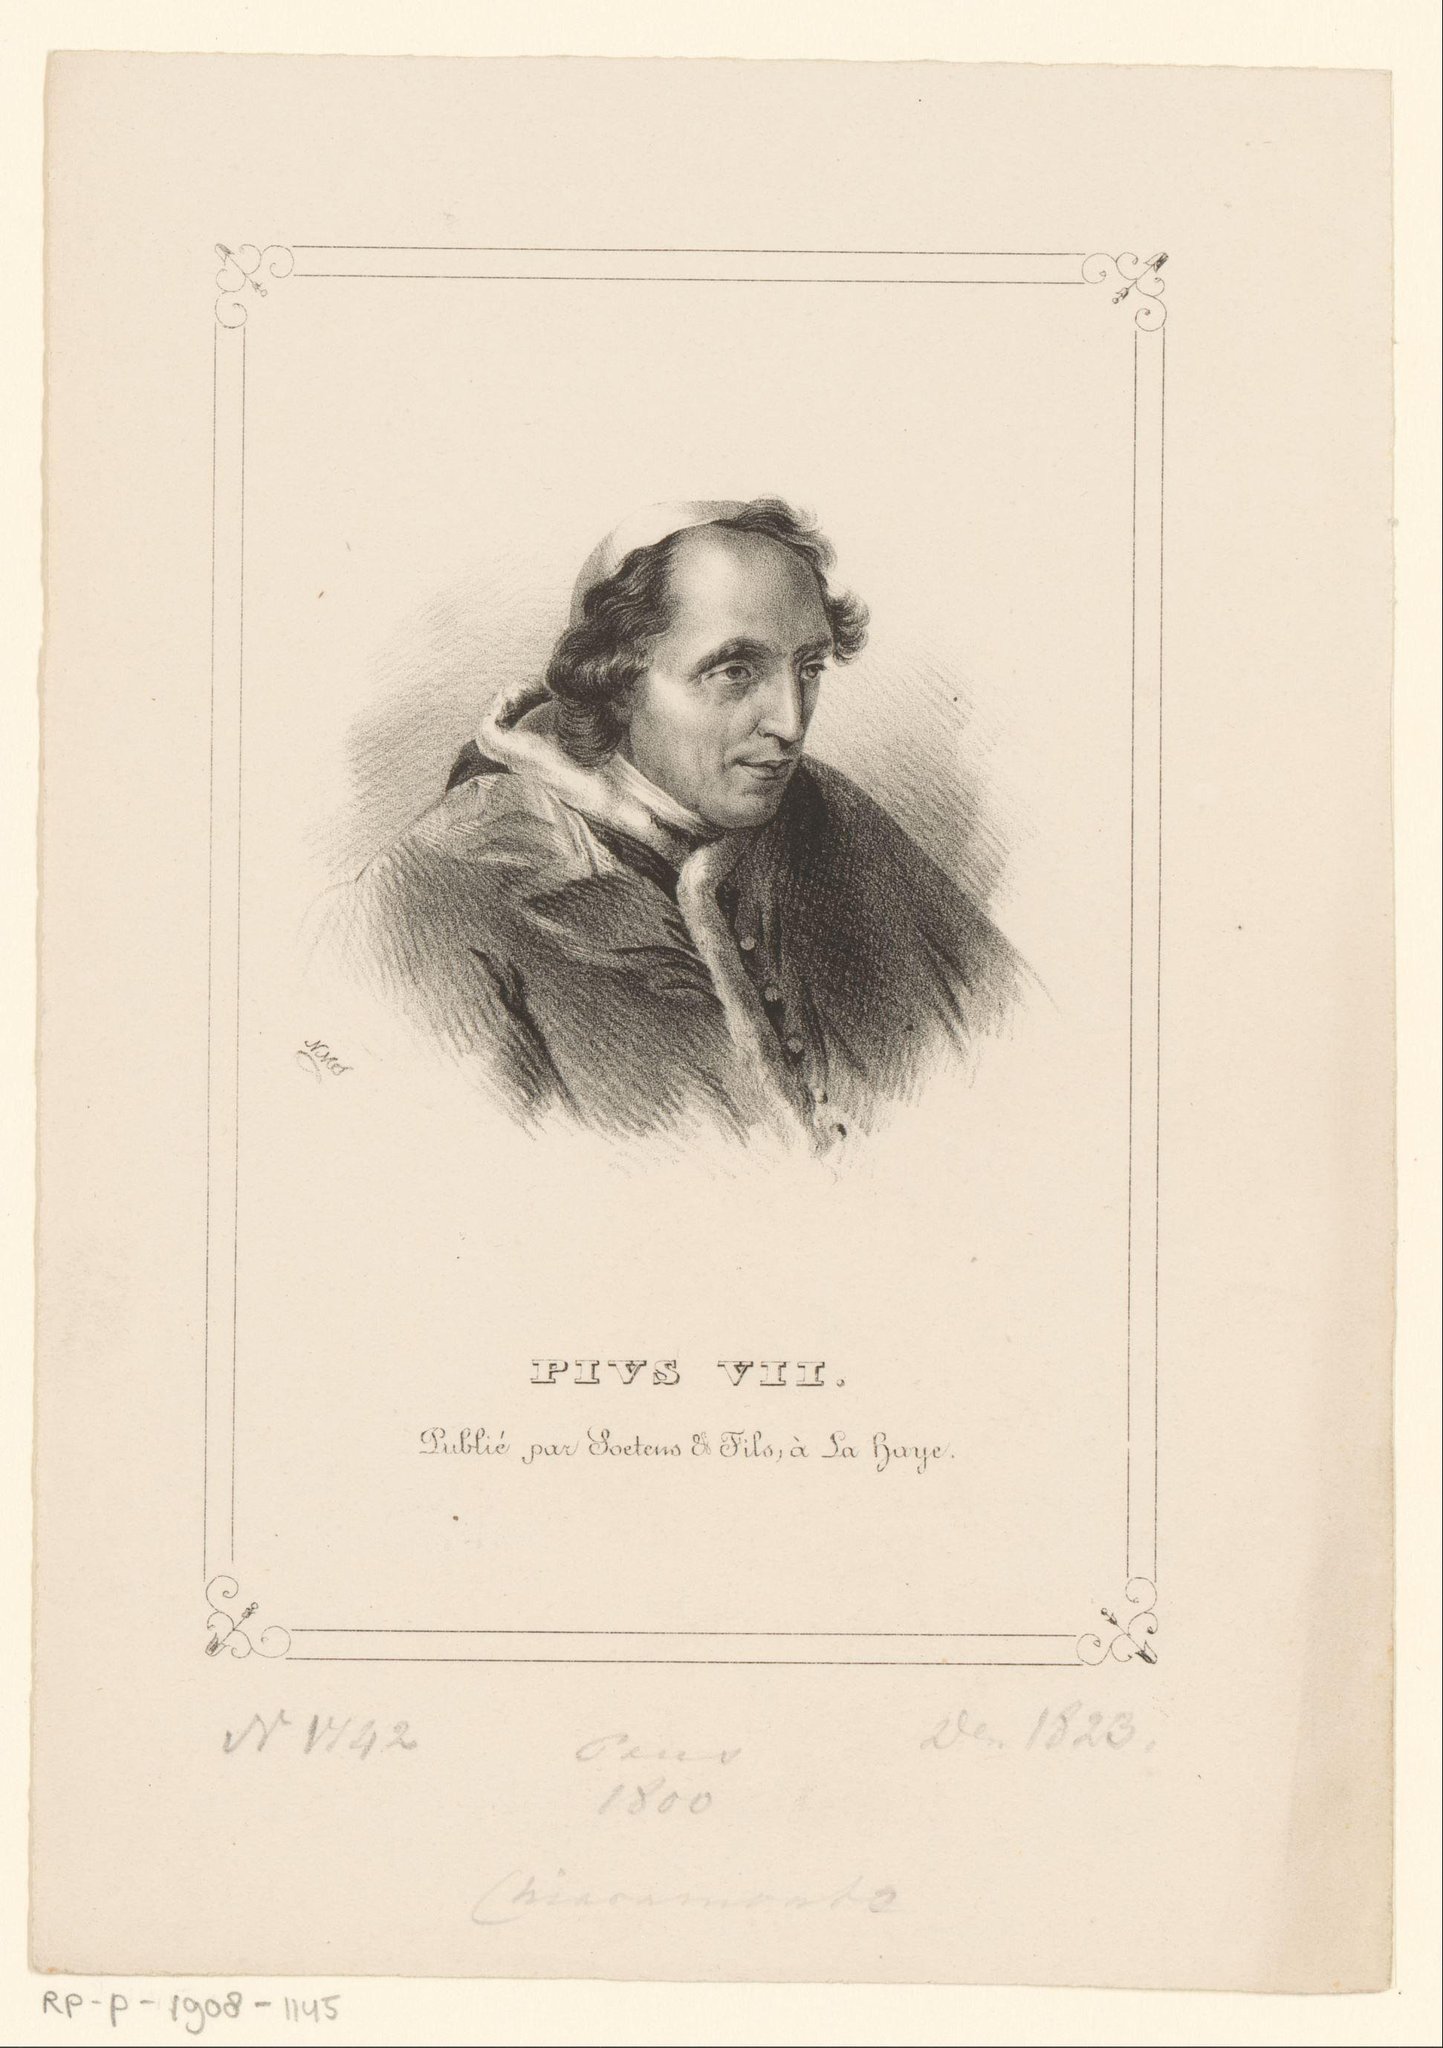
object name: print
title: Portret van paus Pius VII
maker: nicolaas martinus schild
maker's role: draughtsman, print maker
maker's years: 1822-1840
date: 1837-1840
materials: paper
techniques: lithograph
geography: the hague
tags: historical persons (+ (full) bust portrait), pope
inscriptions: collector's mark: Lugt 2228